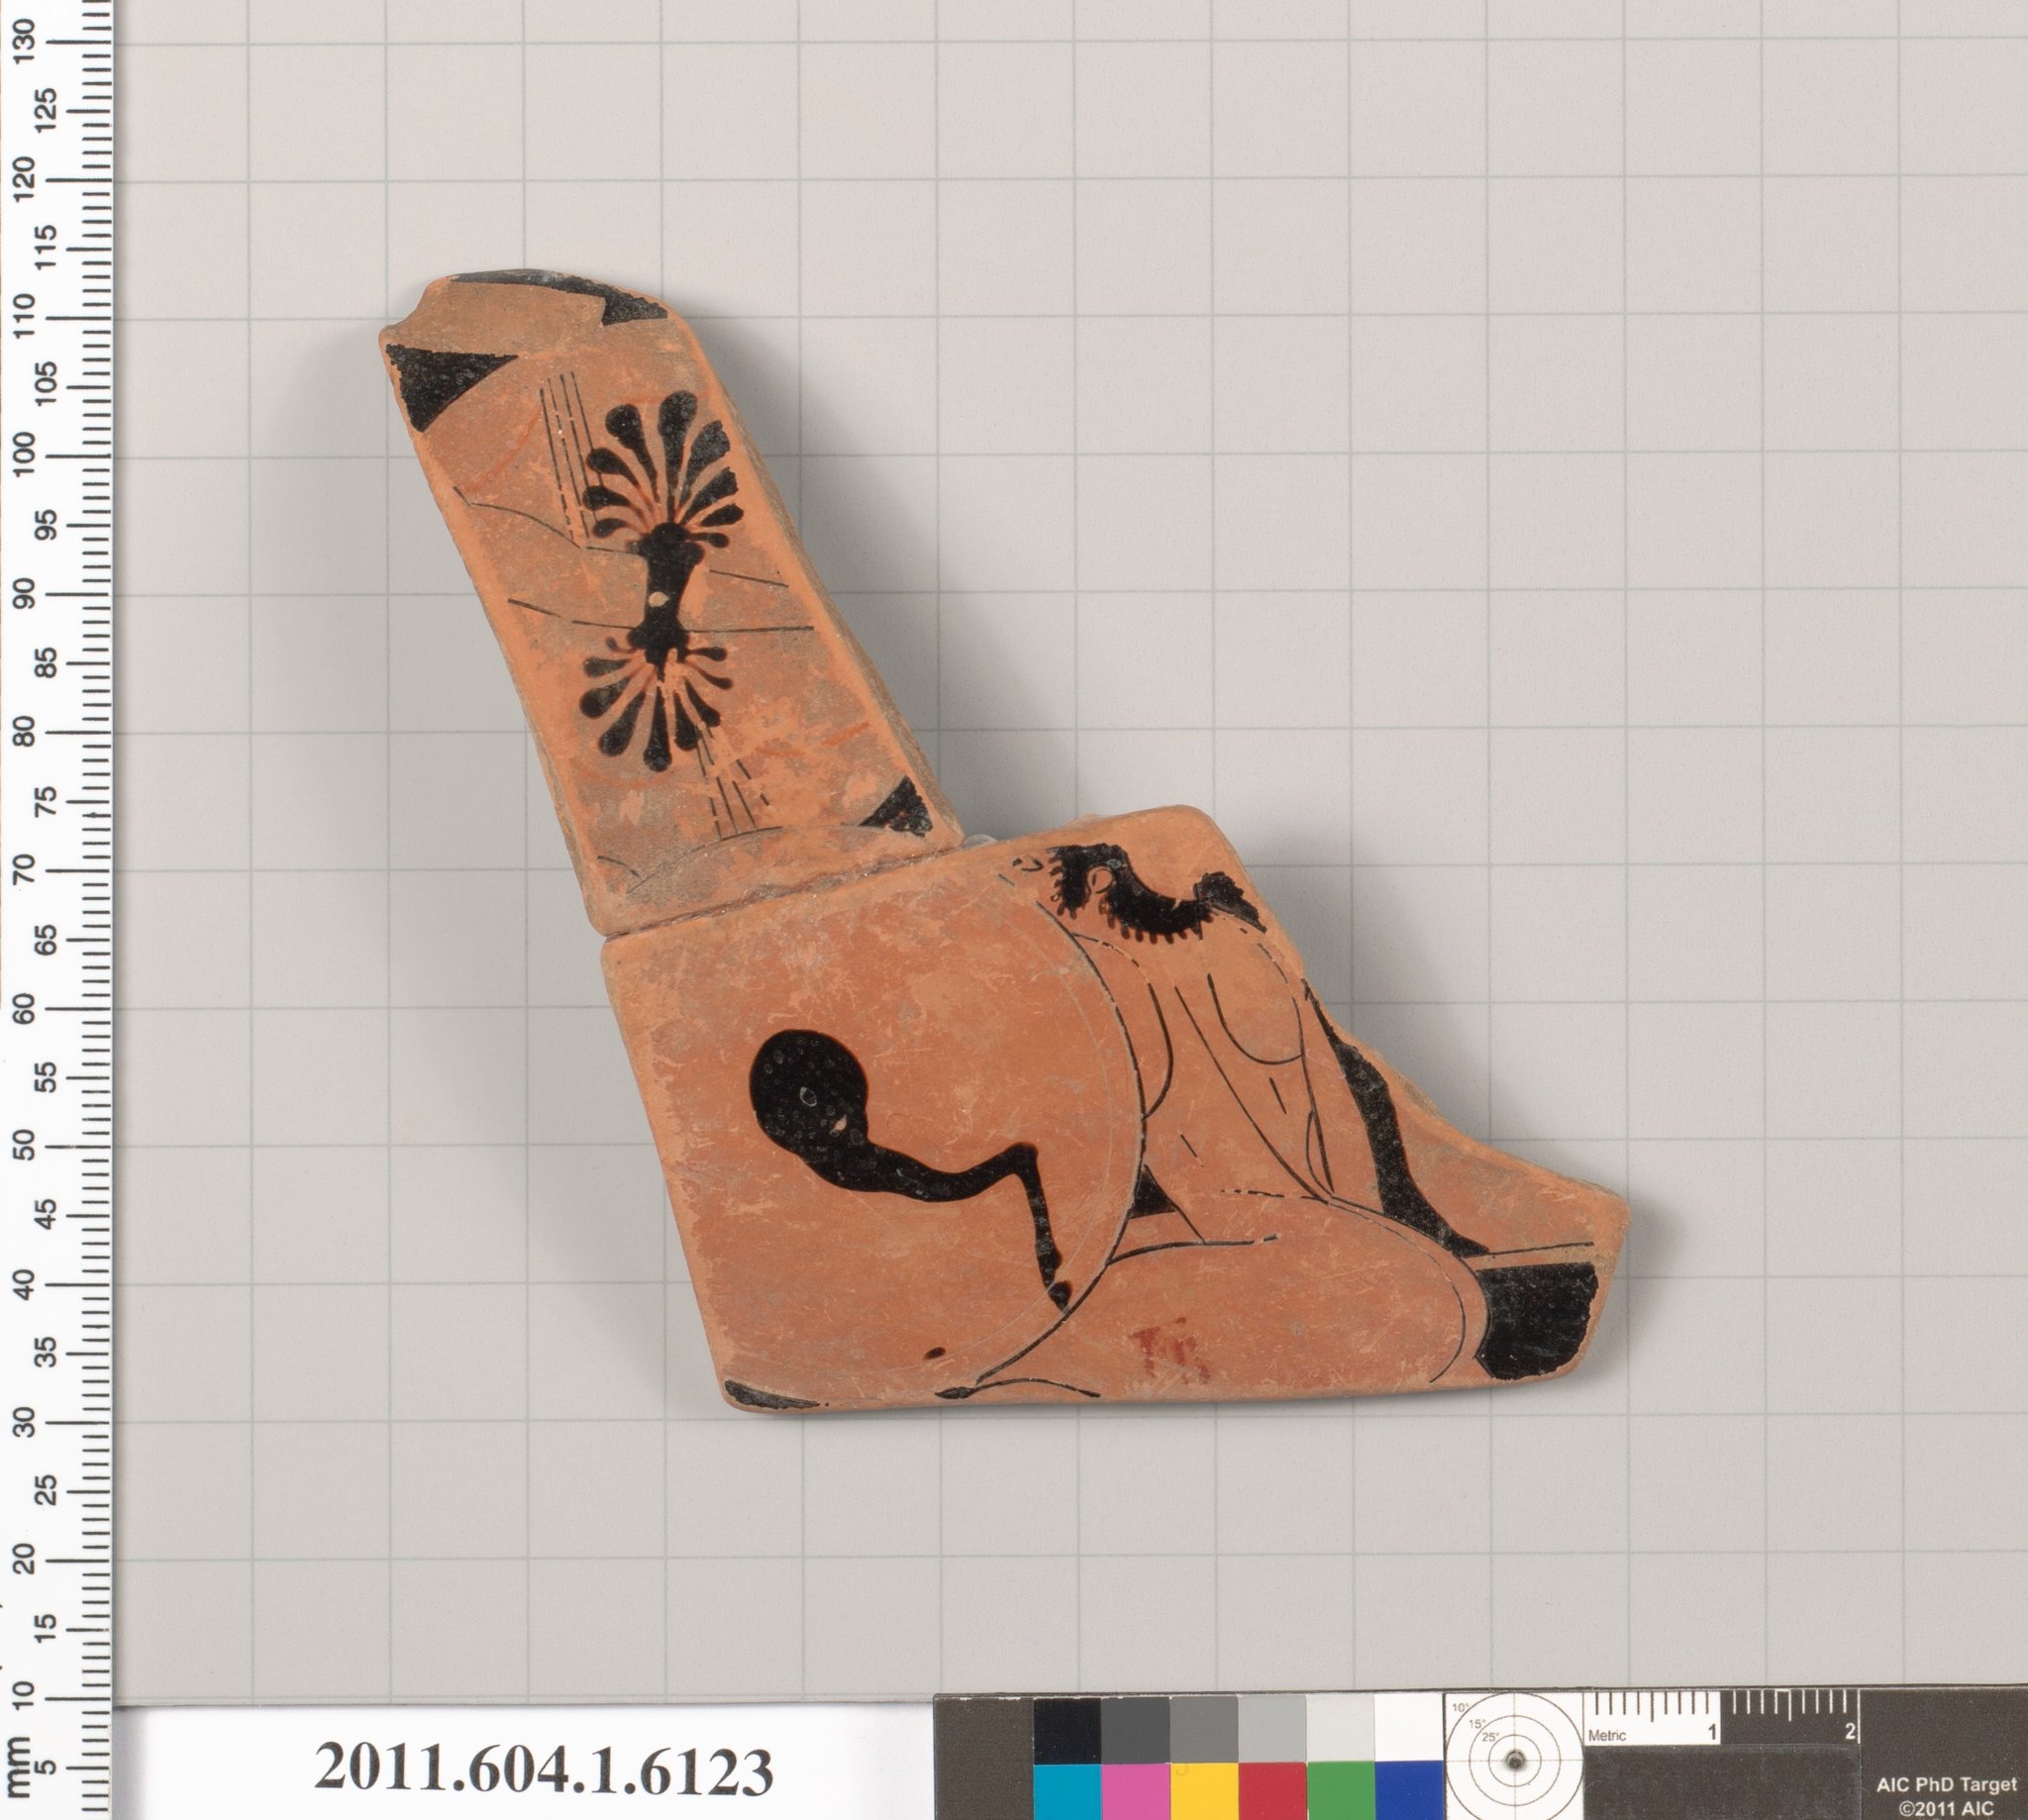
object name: kylix fragment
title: Terracotta fragment of a kylix (drinking cup)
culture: greek, attic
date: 520-500 BCE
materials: terracotta